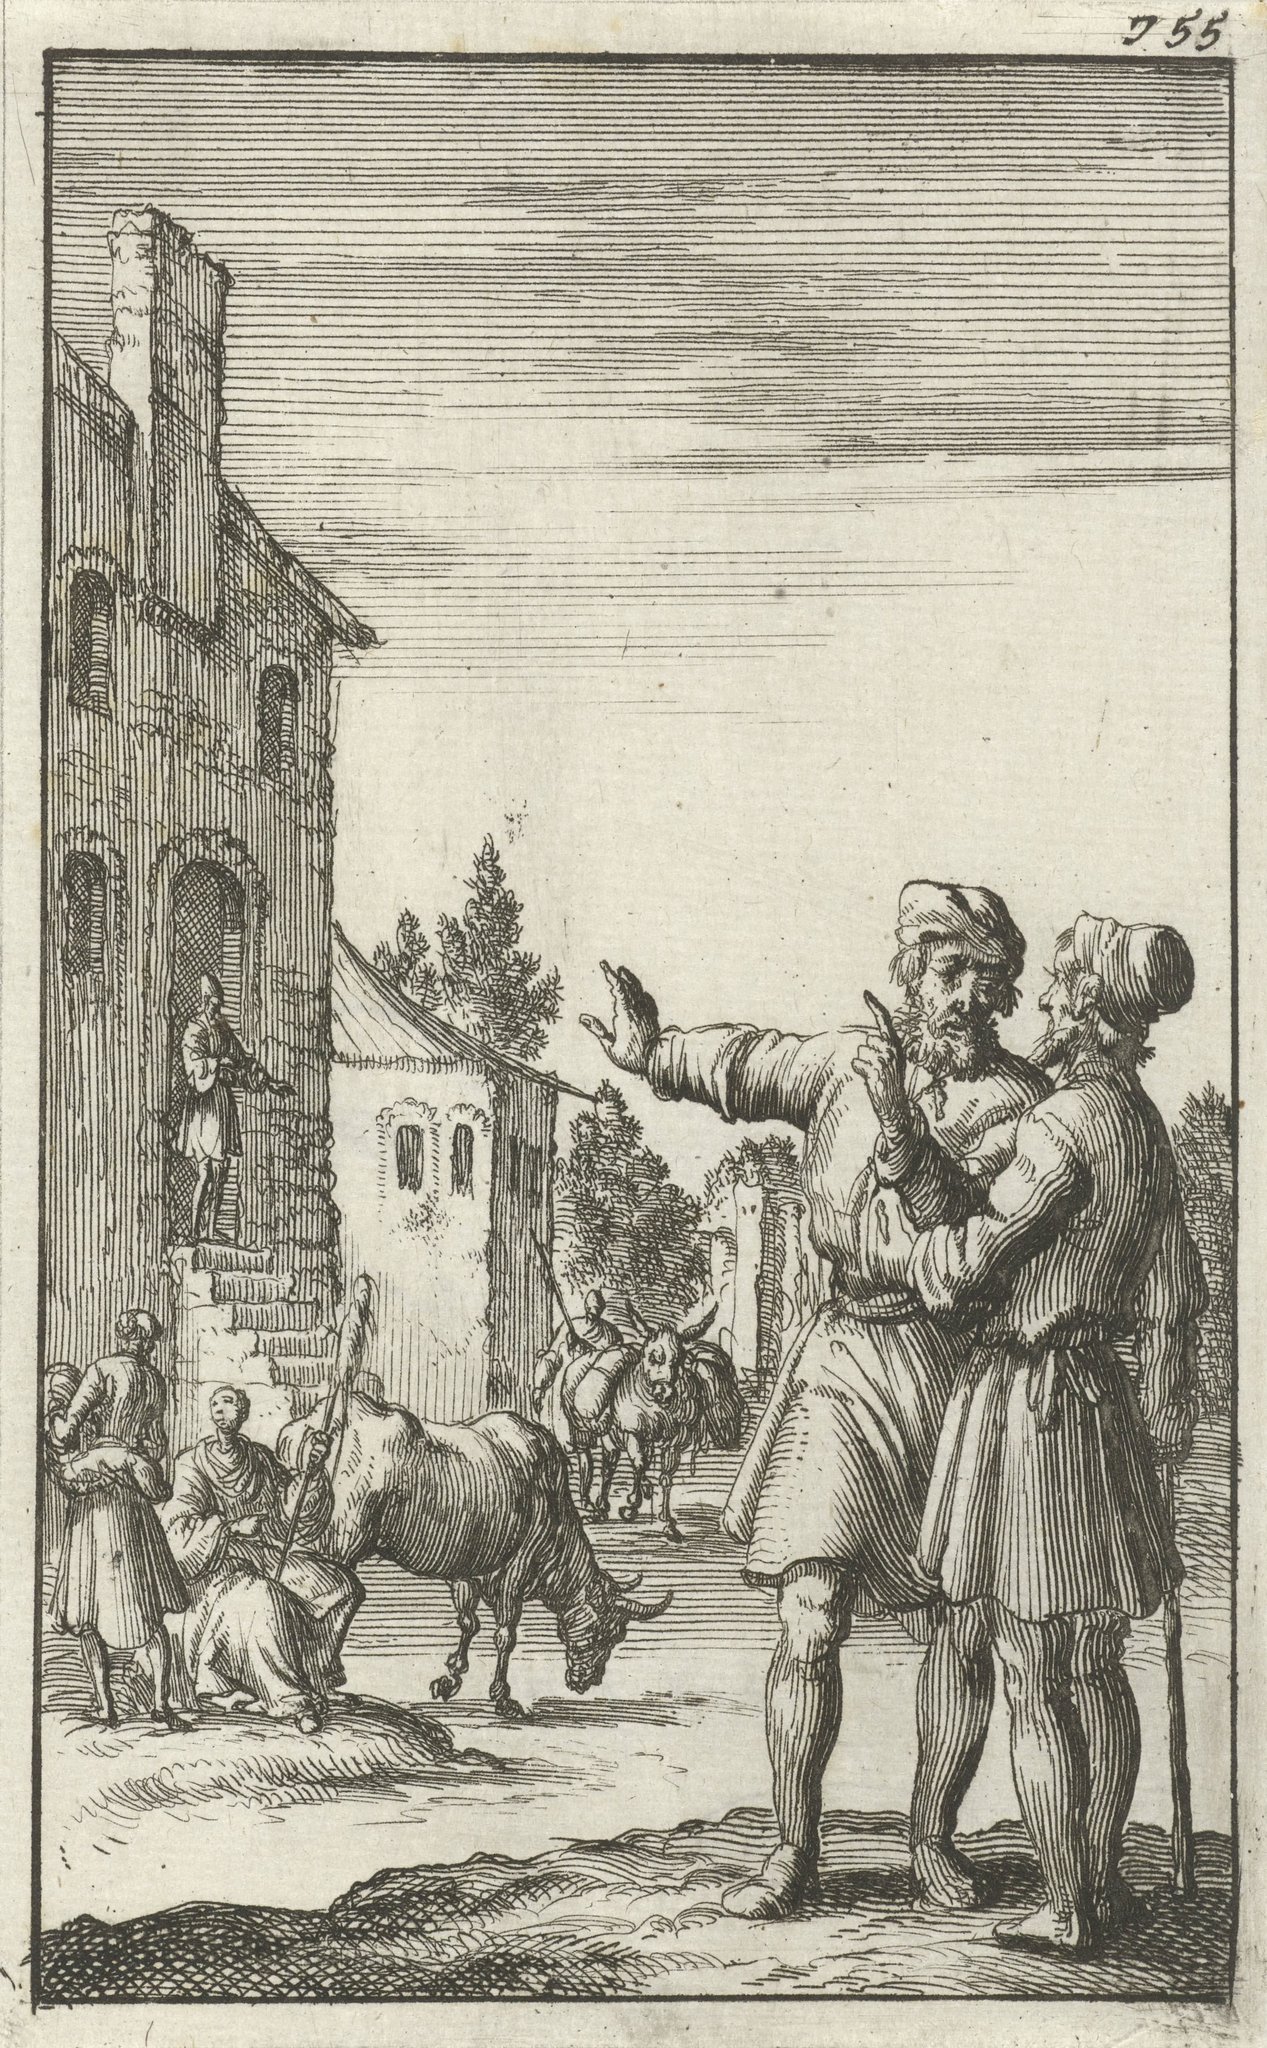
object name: book illustration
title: Gij zult niet onrechtvaardig begeren wat uw naaste toebehoort: het tiende Gebod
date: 1685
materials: paper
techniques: etching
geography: amsterdam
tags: neighbour, magistracy, judges, civic architecture; edifices; dwellings, index finger forwards, pointing, indicating, 'you shall not covet' ~ separate representation of the tenth of the ten commandments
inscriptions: collector's mark: Lugt 2228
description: Illustratie uit: Hondorffius, Andreas. De tien geboden des Heeren. Amsterdam: Jan Bouman, 1685.